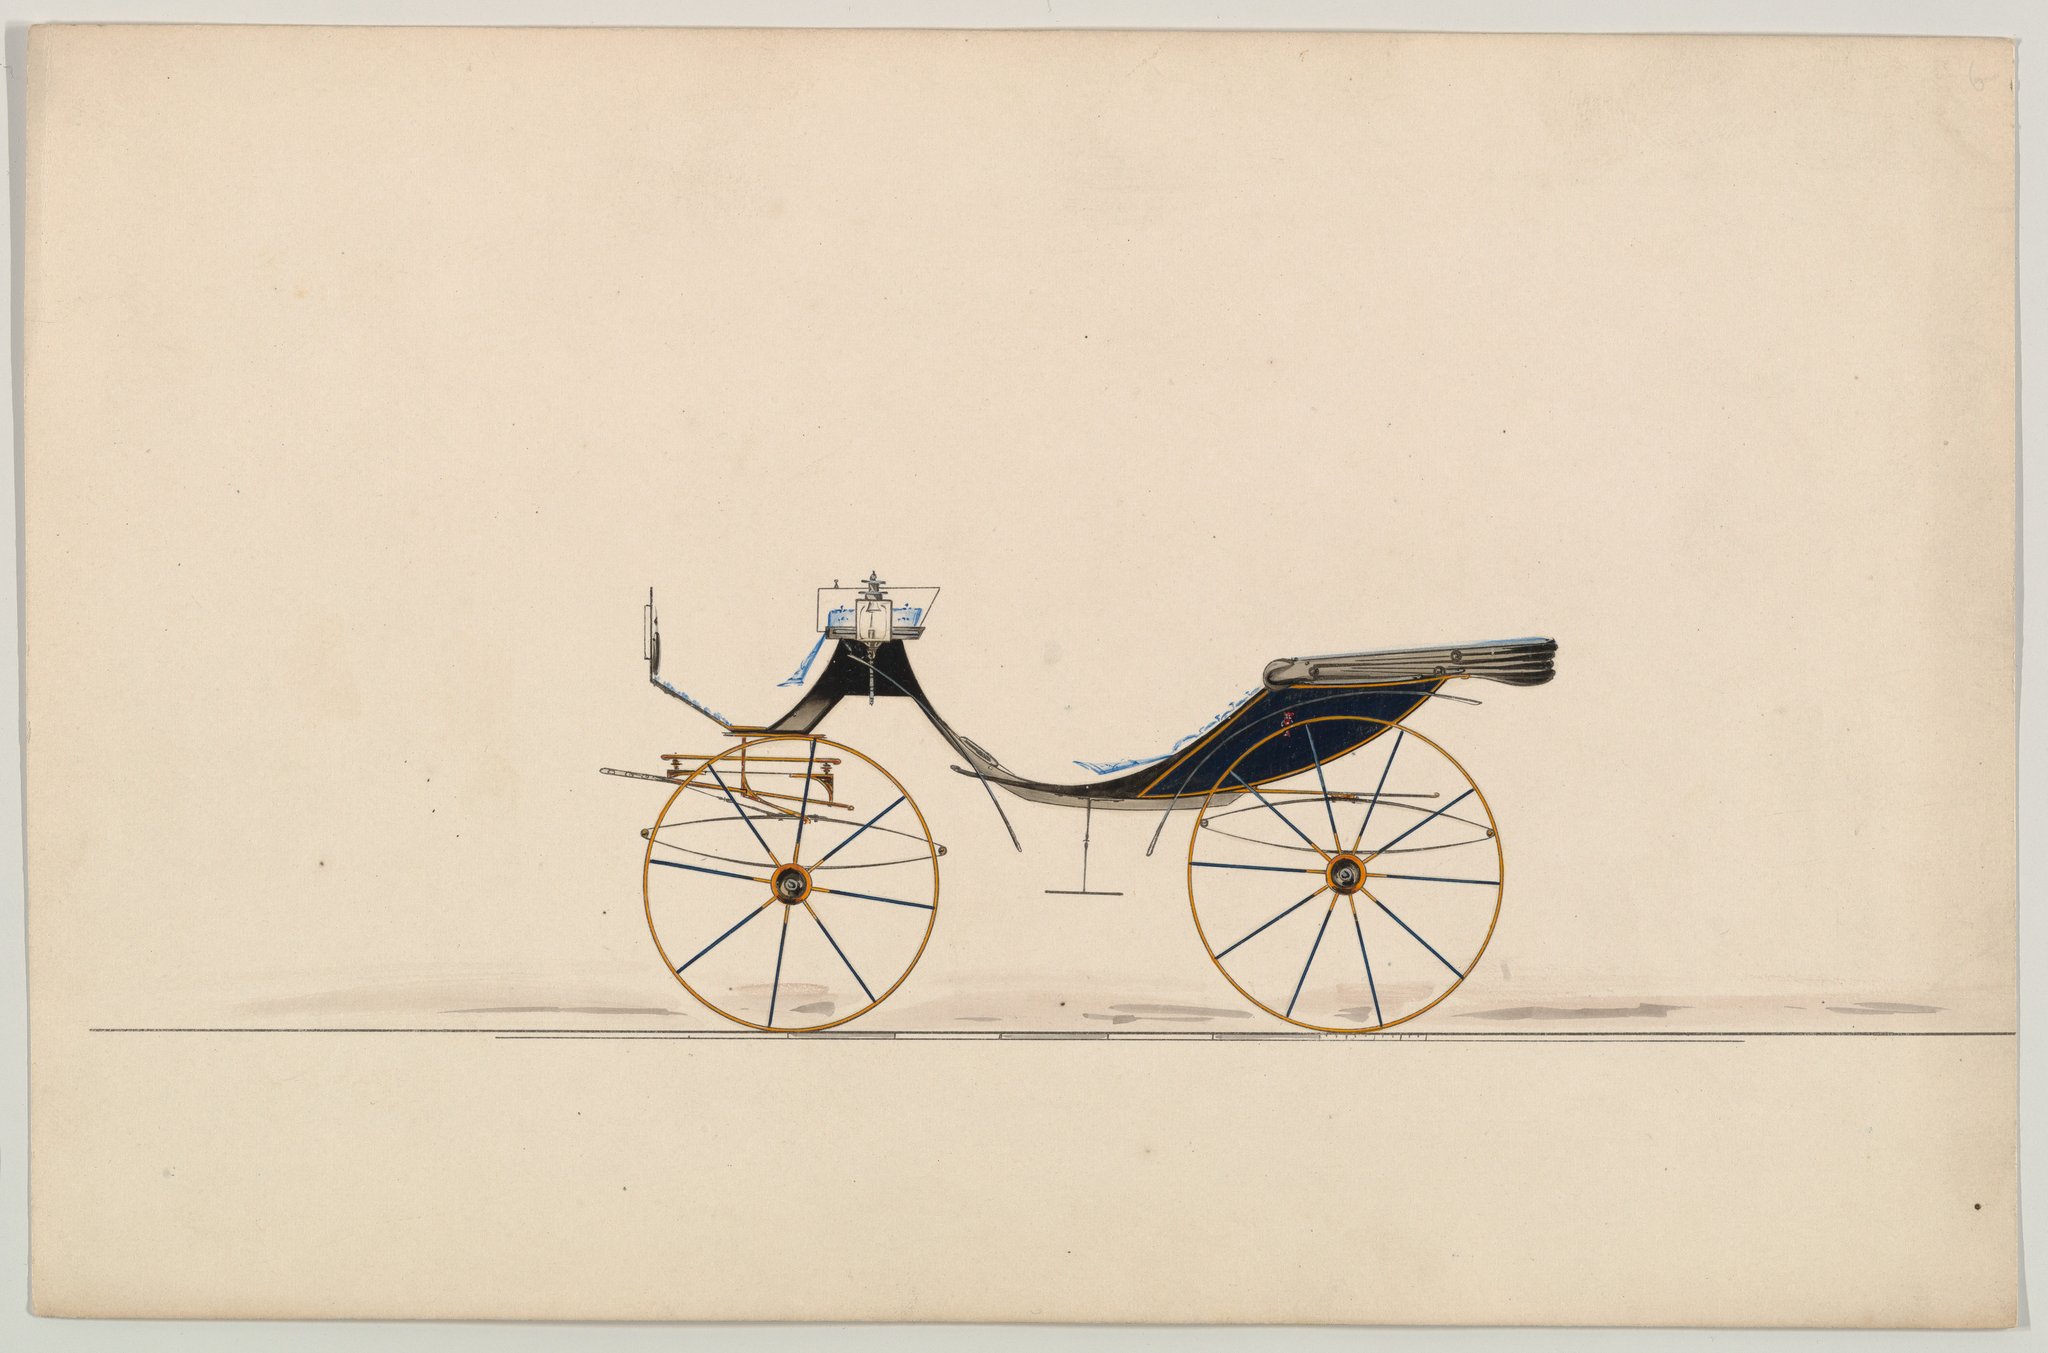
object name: drawing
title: Cabriolet (unnumbered)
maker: brewster & co.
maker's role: manufacturer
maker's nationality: american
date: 1870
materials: gouache, gum arabic, ink, watercolor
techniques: pen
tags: carriages